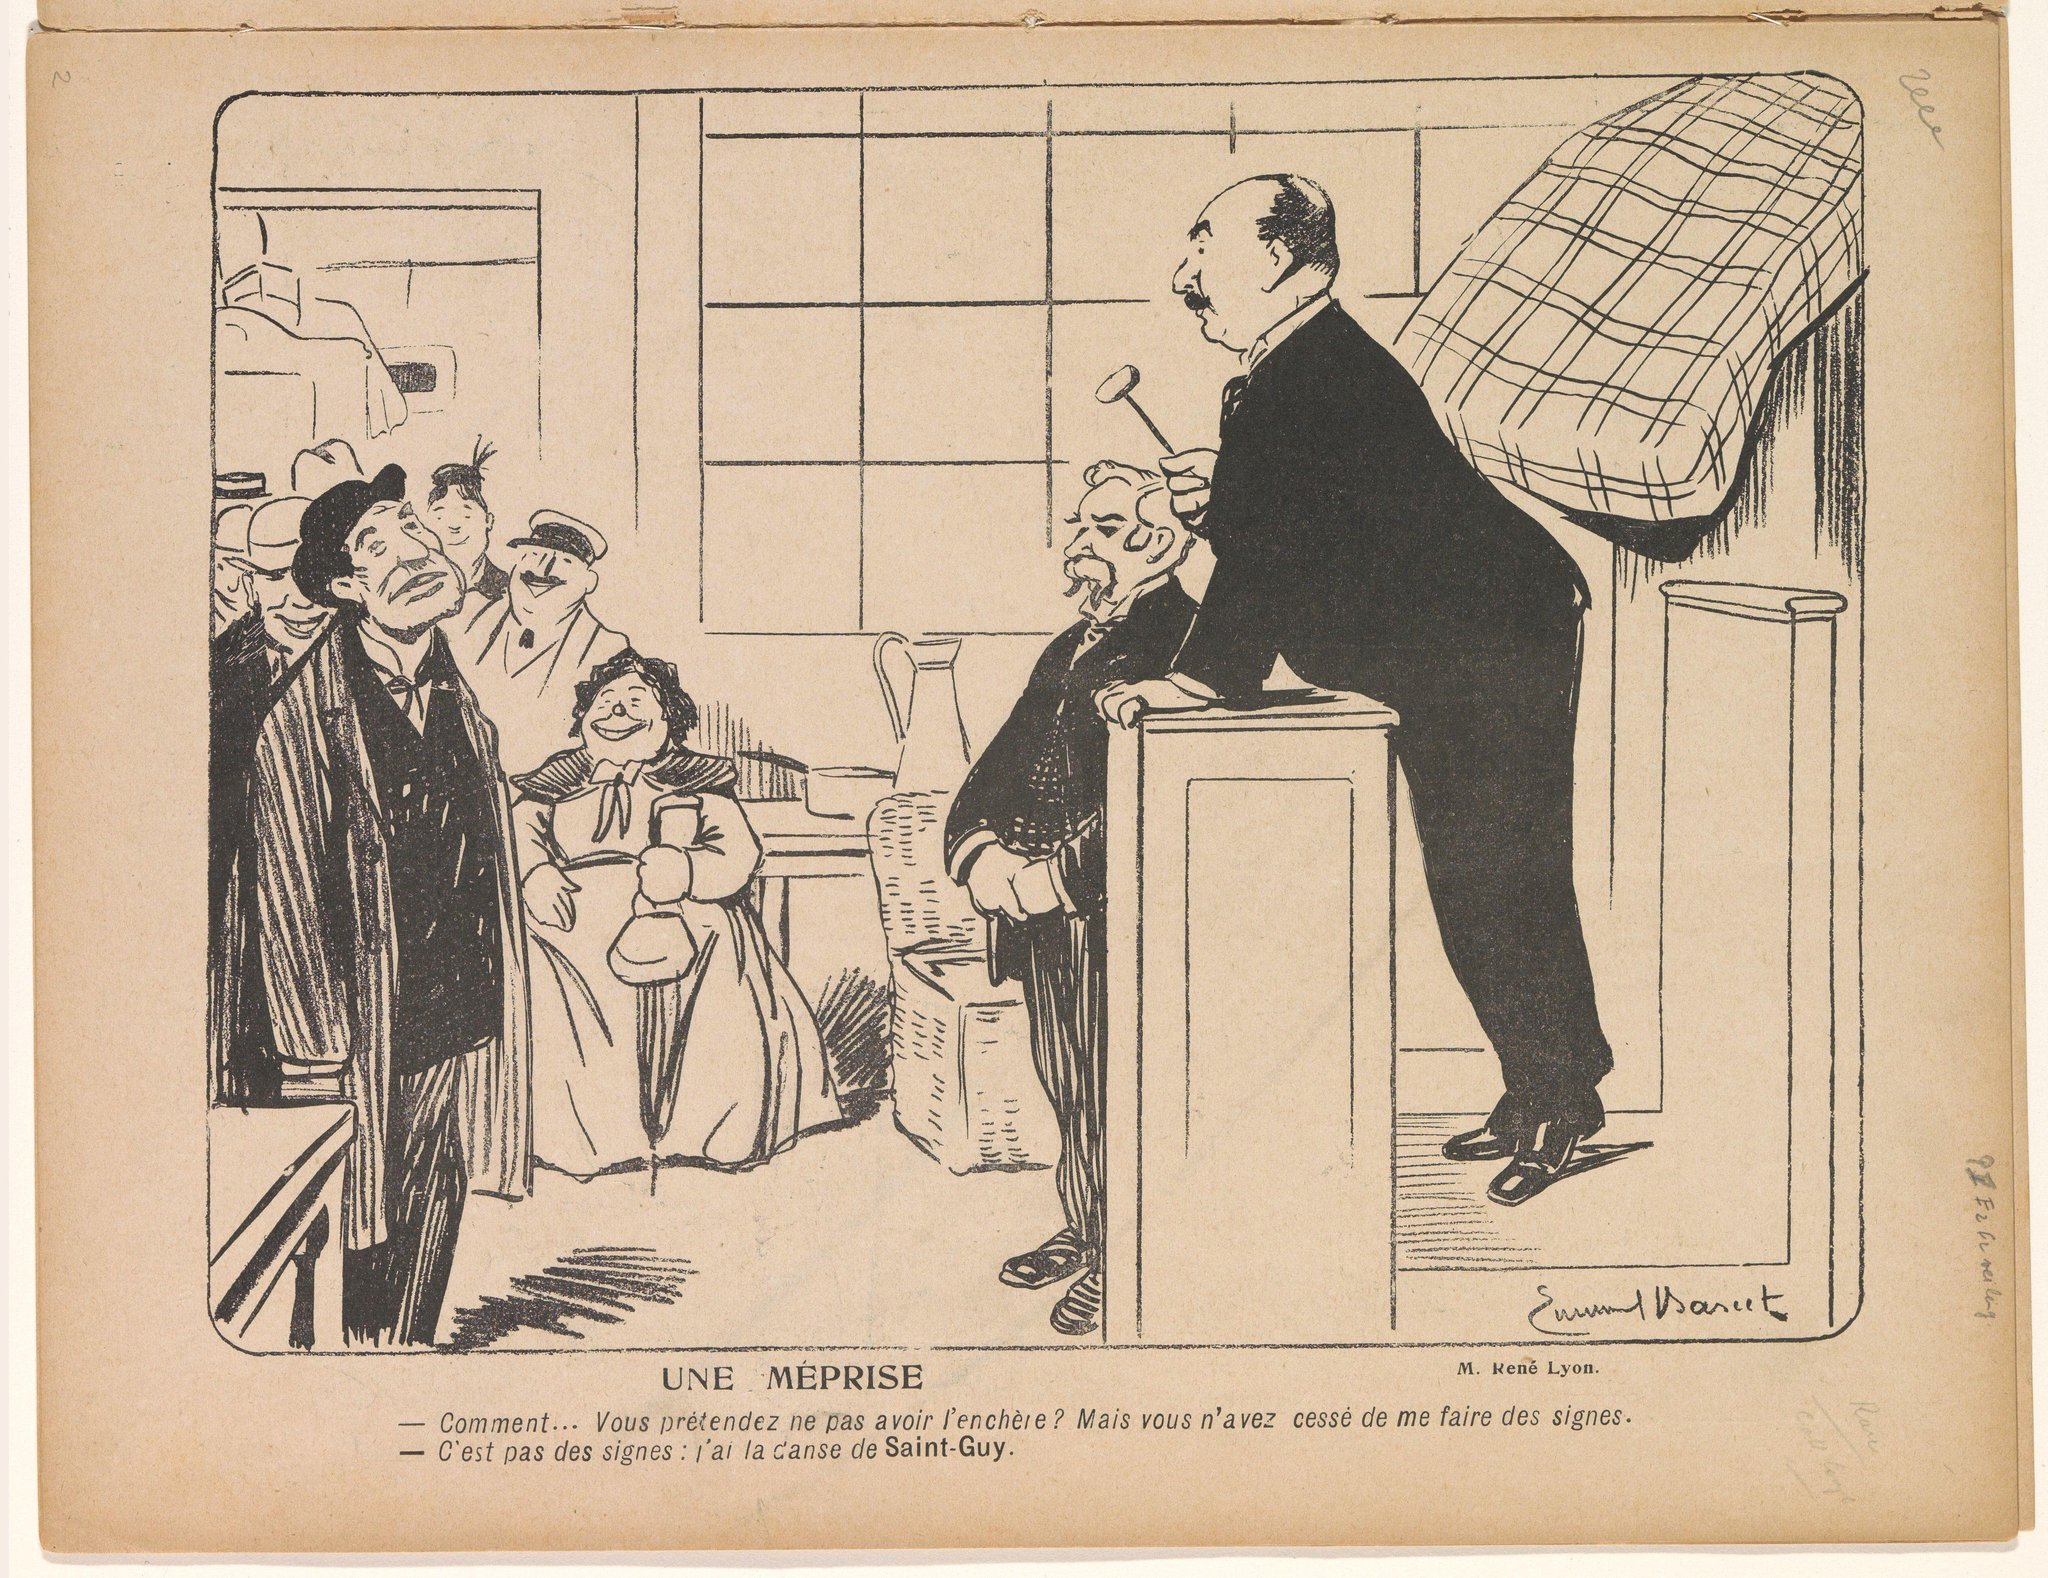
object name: magazine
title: Vergissing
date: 1905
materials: paper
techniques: lithograph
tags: caricatures (human types), art sale, auction, political caricatures and satires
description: De veilingmeester, waarschijnlijk René Lyon, is in gesprek met een bieder. Een kavel is aan hem toegeslagen omdat hij schokkerige bewegingen maakt die oorzaak zijn van een ziekte ('danse de Saint-Guy'). Linksonder genummerd: 115. De prent maakt onderdeel uit van een tijdschrift.